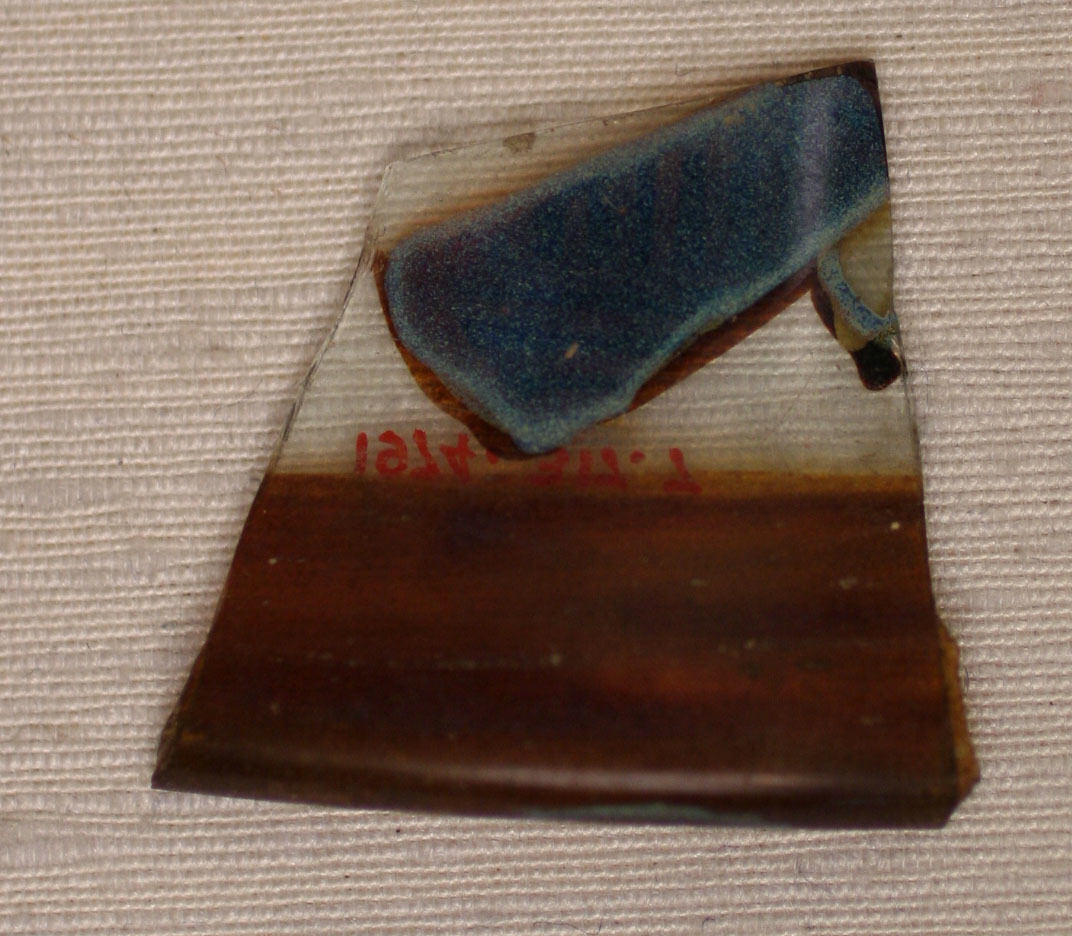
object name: fragment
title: Glass Fragment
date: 801-900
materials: glass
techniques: luster painting, stain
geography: egypt or iraq